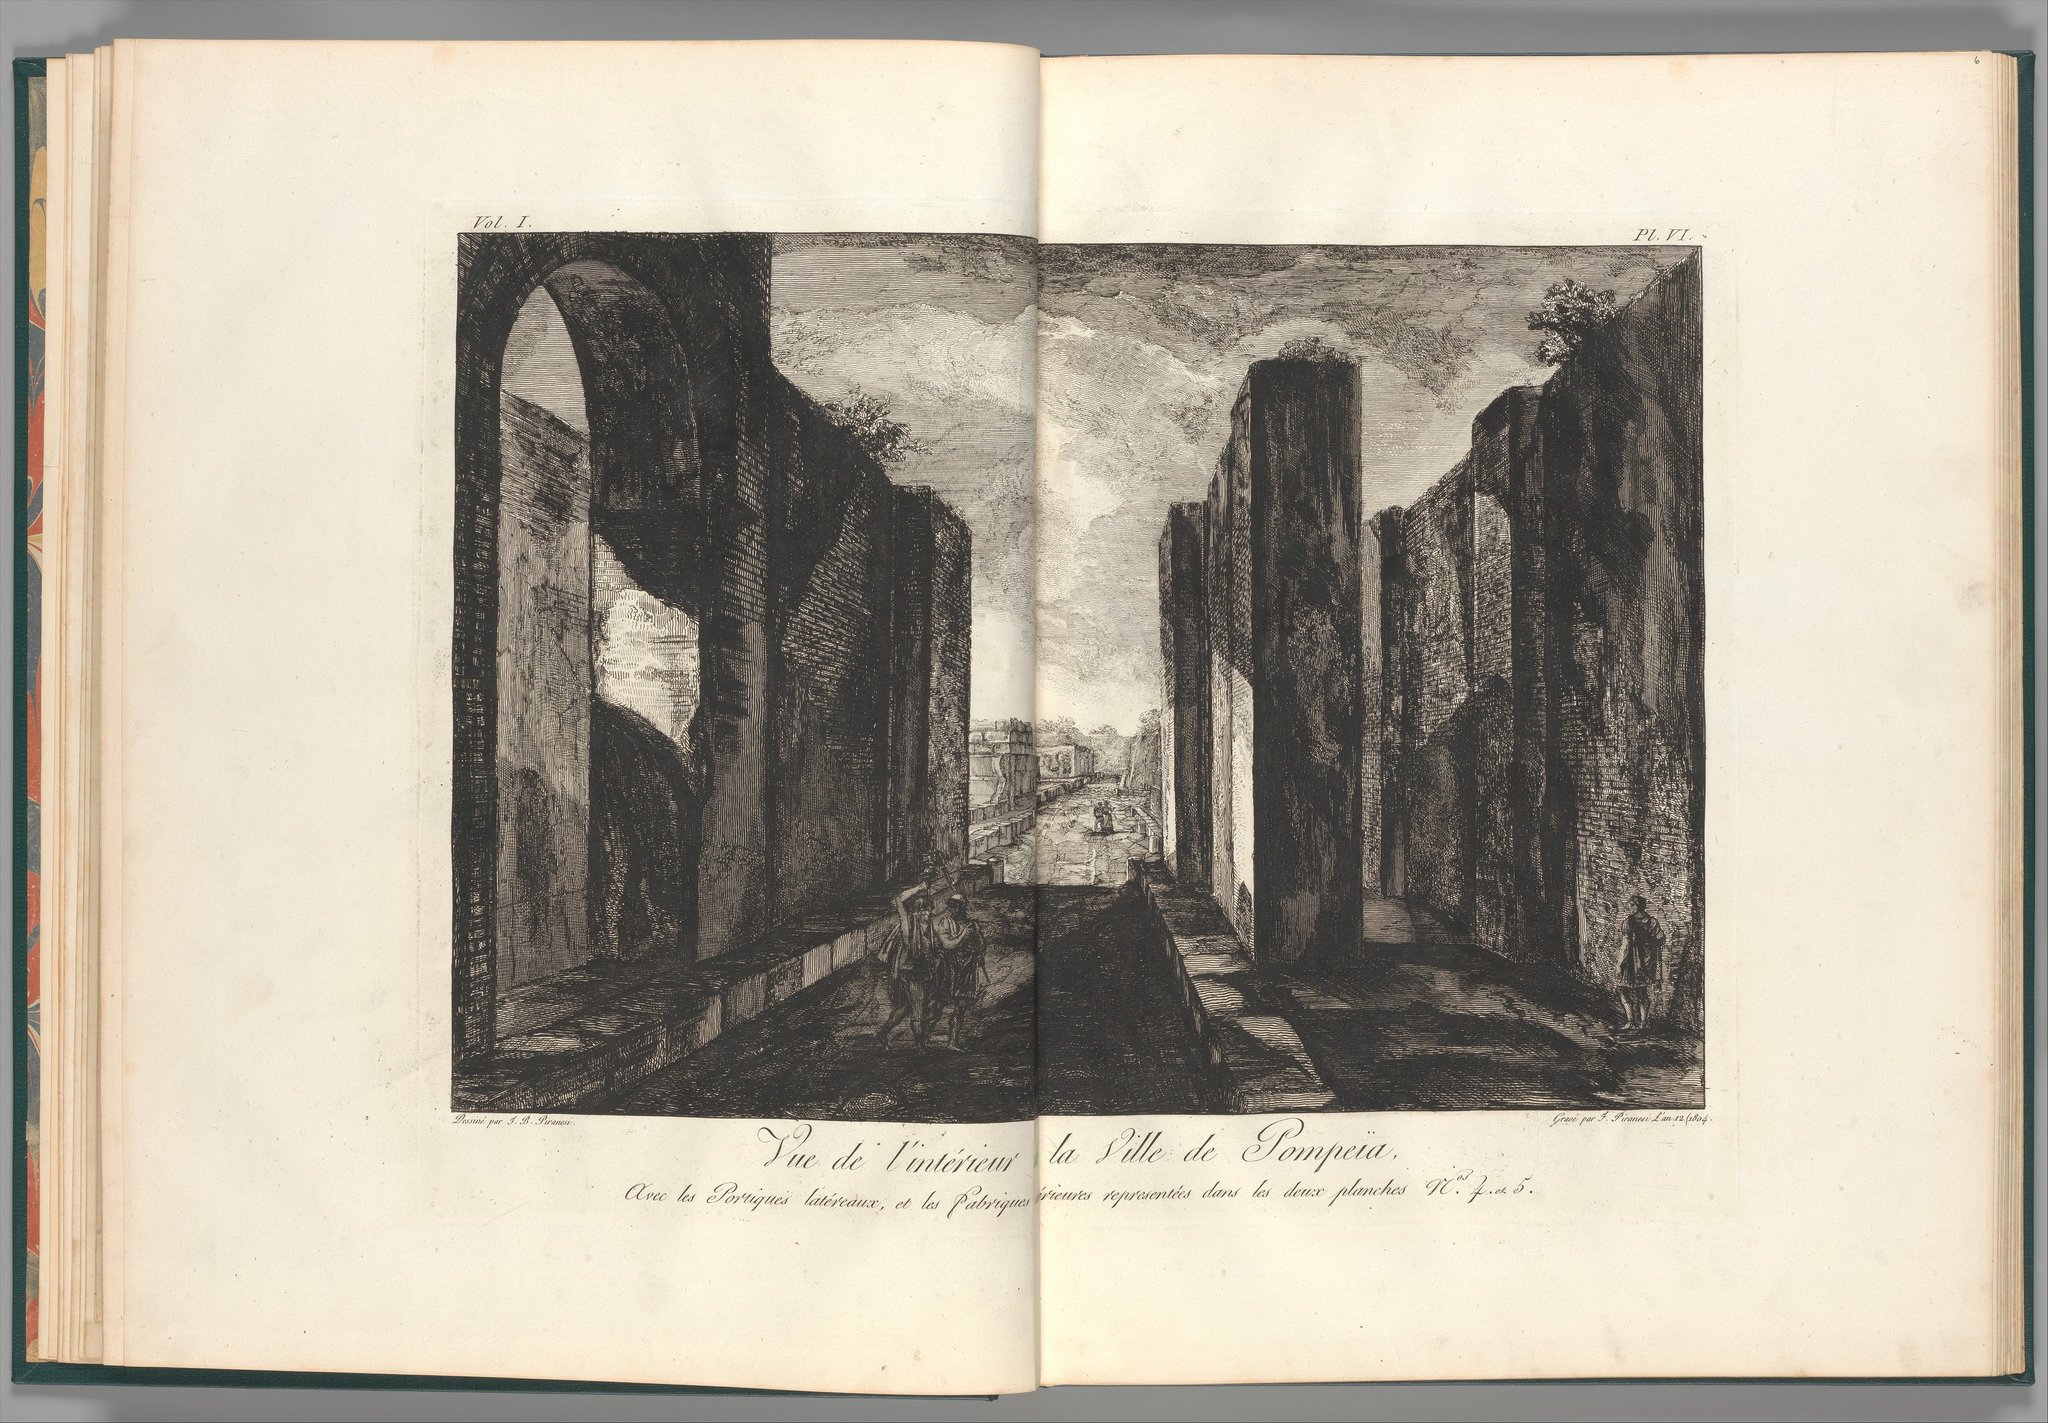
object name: print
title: View of the interior of the city of Pompeii, from "Antiquités de Pompeïa, tome premier, Antiquités de la Grande Grèce..." (Antiquities of Pompeii, volume one, Antiquities of Great Greece...), volume 1, plate 6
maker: francesco piranesi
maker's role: artist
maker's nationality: italian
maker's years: 1758-1810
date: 1804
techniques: etching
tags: cities,ruins